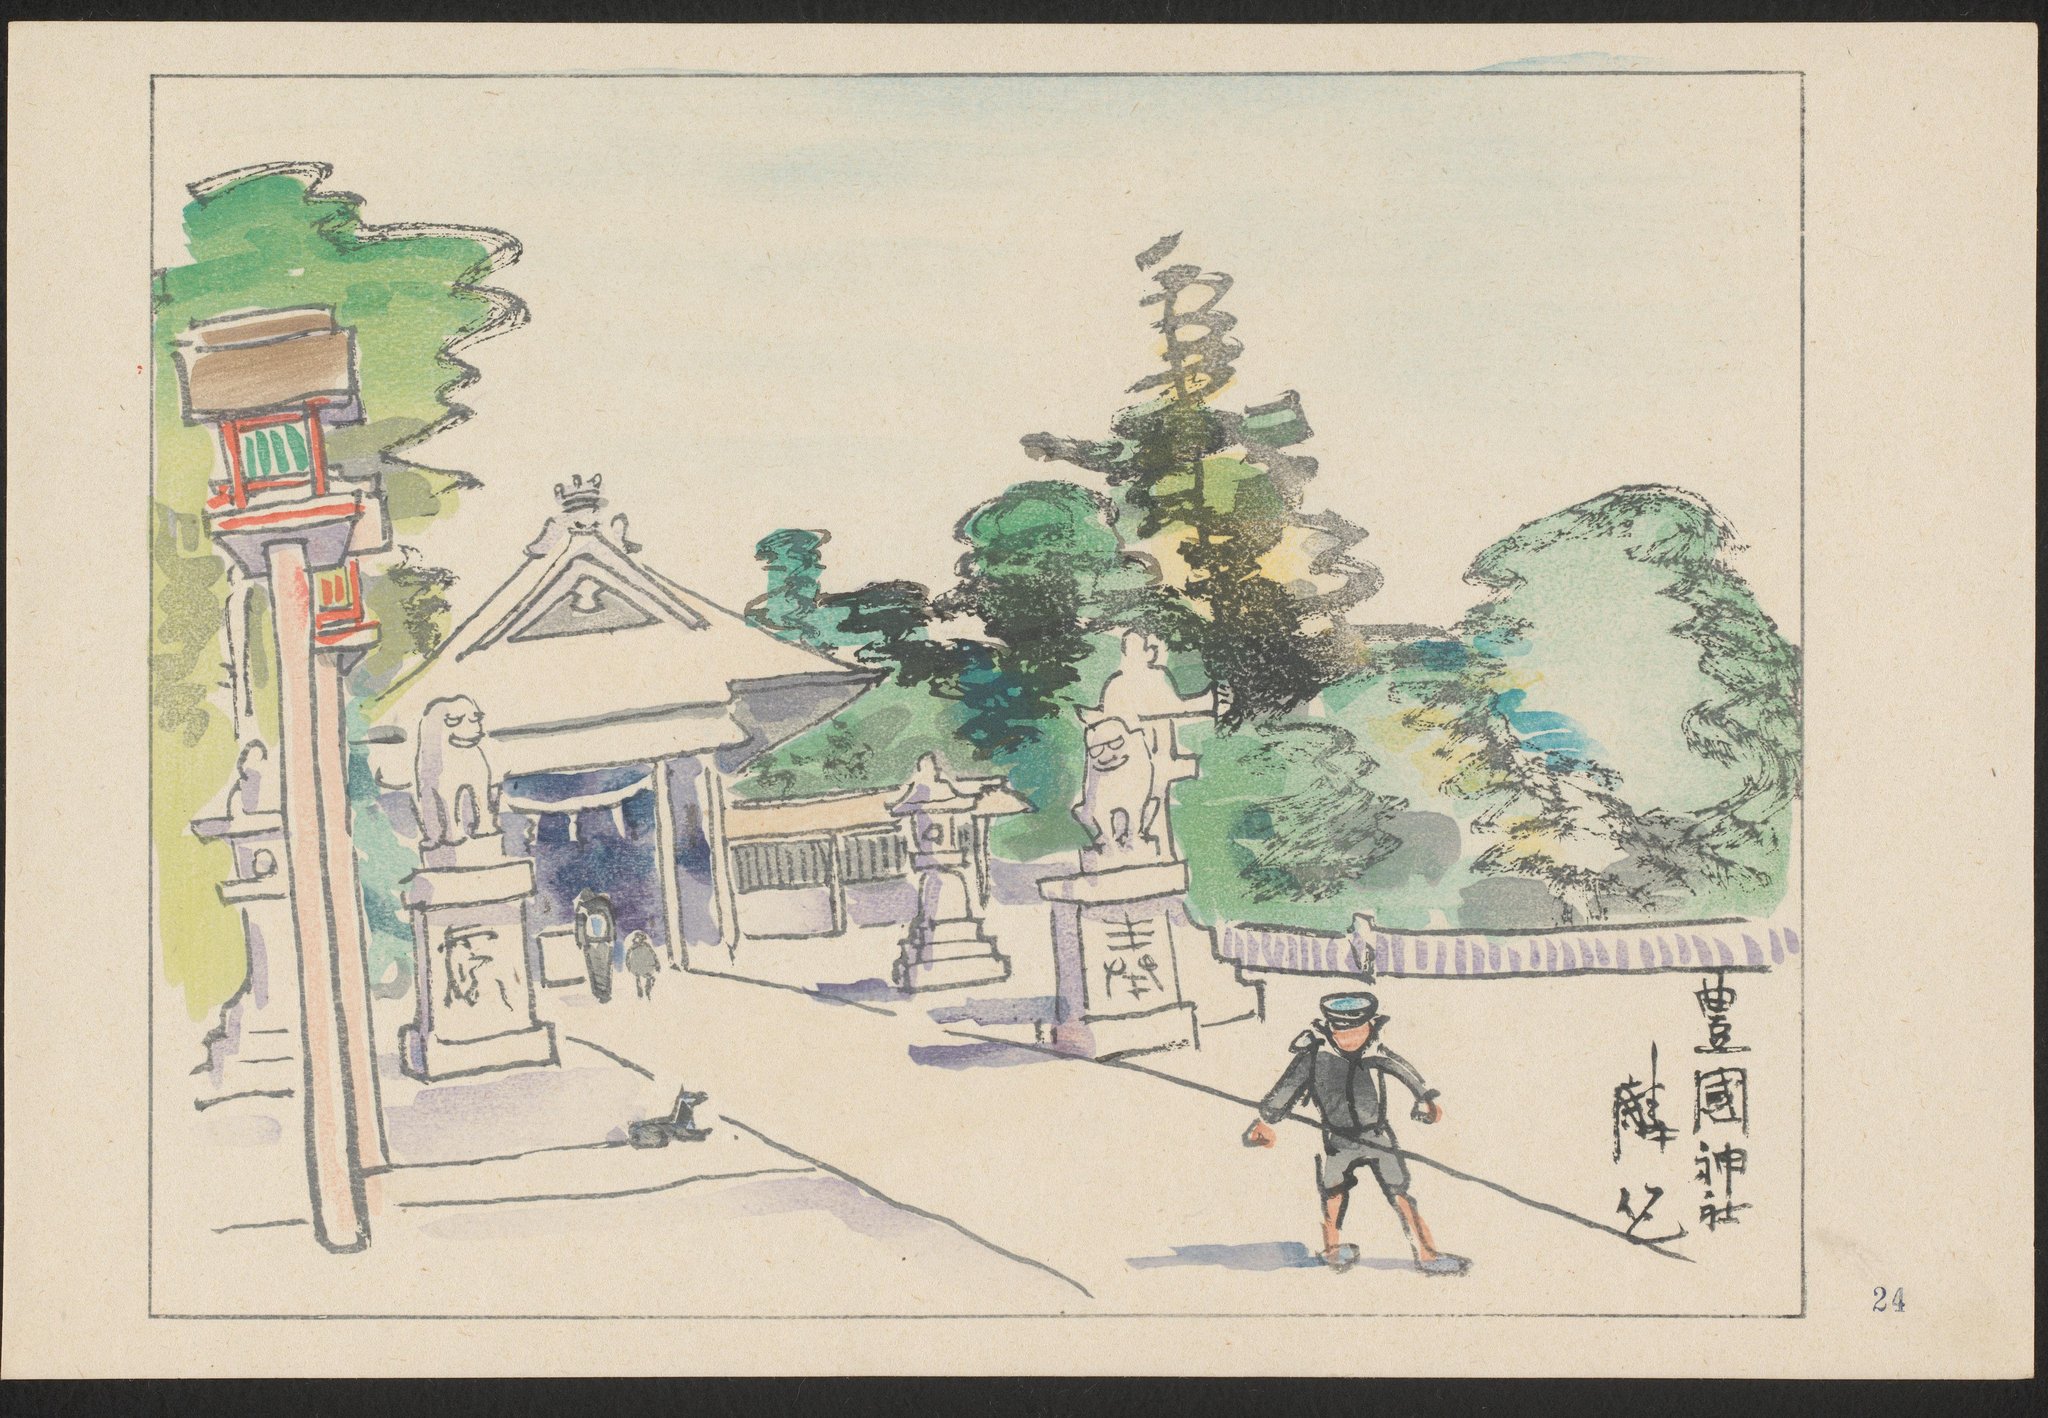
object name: print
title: Toyokuni shrine dedicated to Toyotomi Hideyoshi.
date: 1947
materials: paper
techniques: woodcut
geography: japan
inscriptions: date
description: Gezicht op de ingang van de Toyokuni schrijn, met op de voorgrond een schooljongen.